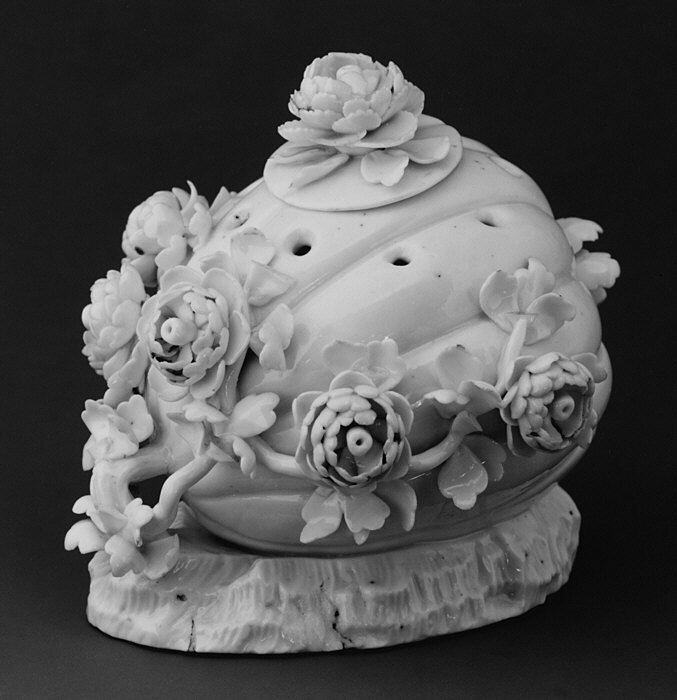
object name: potpourri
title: Potpourri (one of a pair)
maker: saint-cloud factory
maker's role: factory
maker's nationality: french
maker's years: 1693-1766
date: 1730-1750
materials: soft paste porcelain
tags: flowers